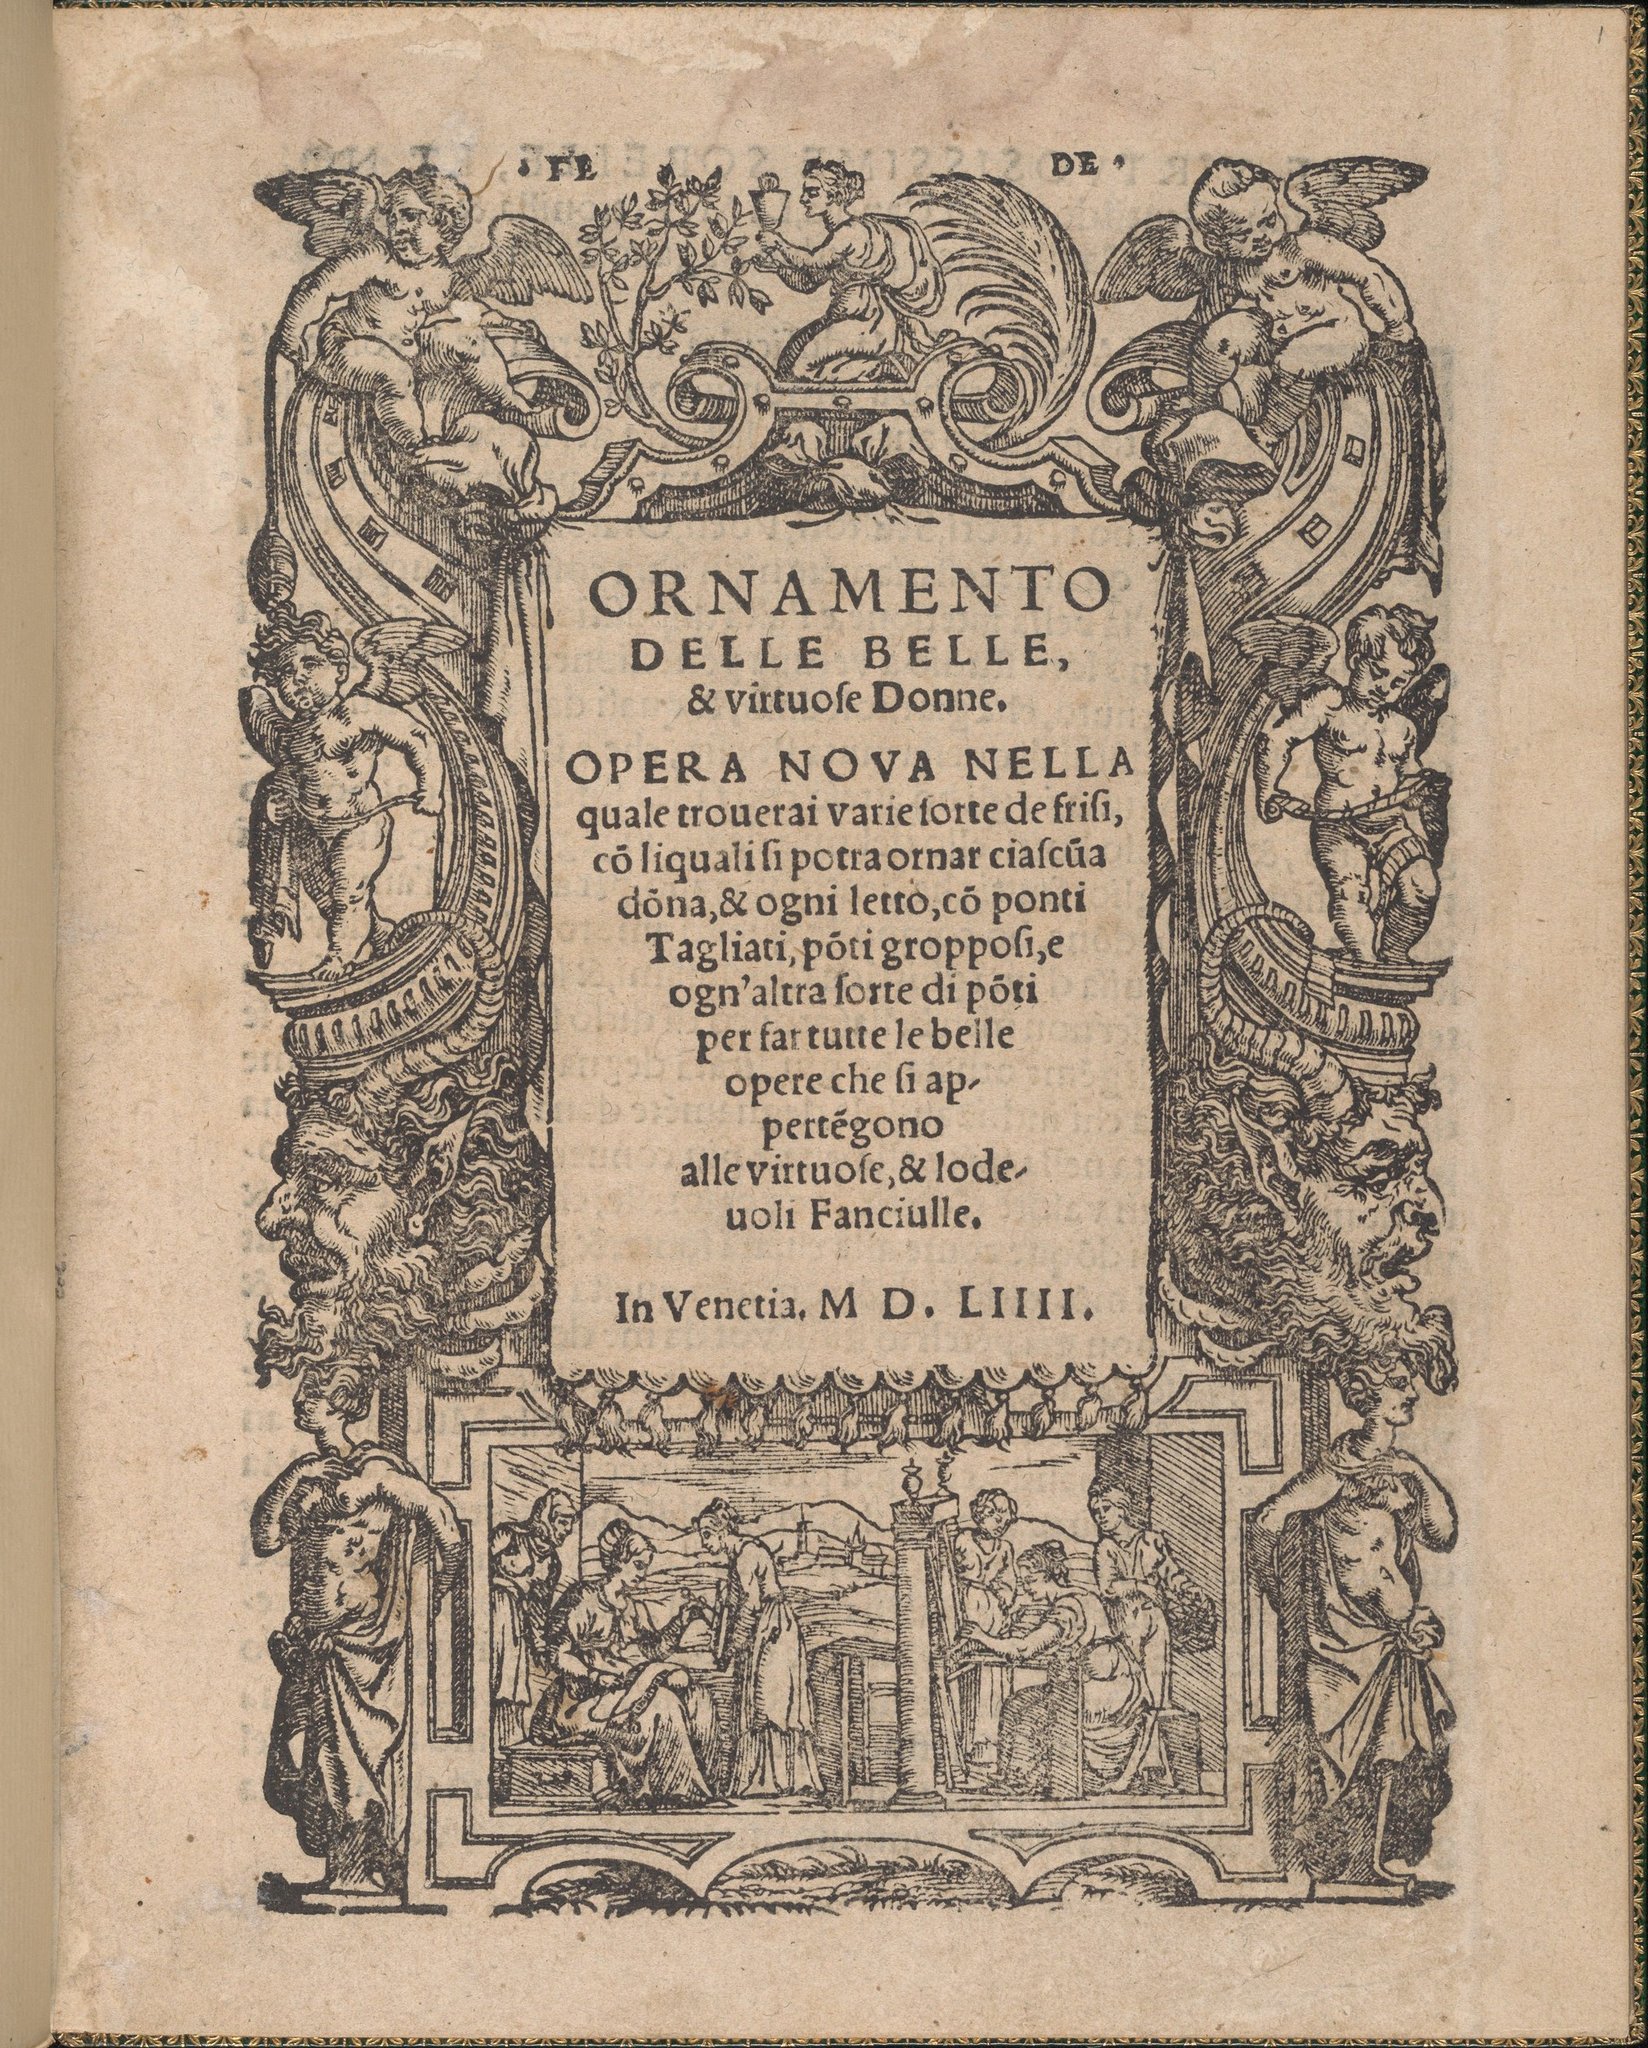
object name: book print ornament architecture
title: Ornamento delle belle & virtuose donne, title page (recto)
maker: matteo pagano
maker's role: publisher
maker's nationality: italian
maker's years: 1515-1588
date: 1554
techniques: woodcut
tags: women